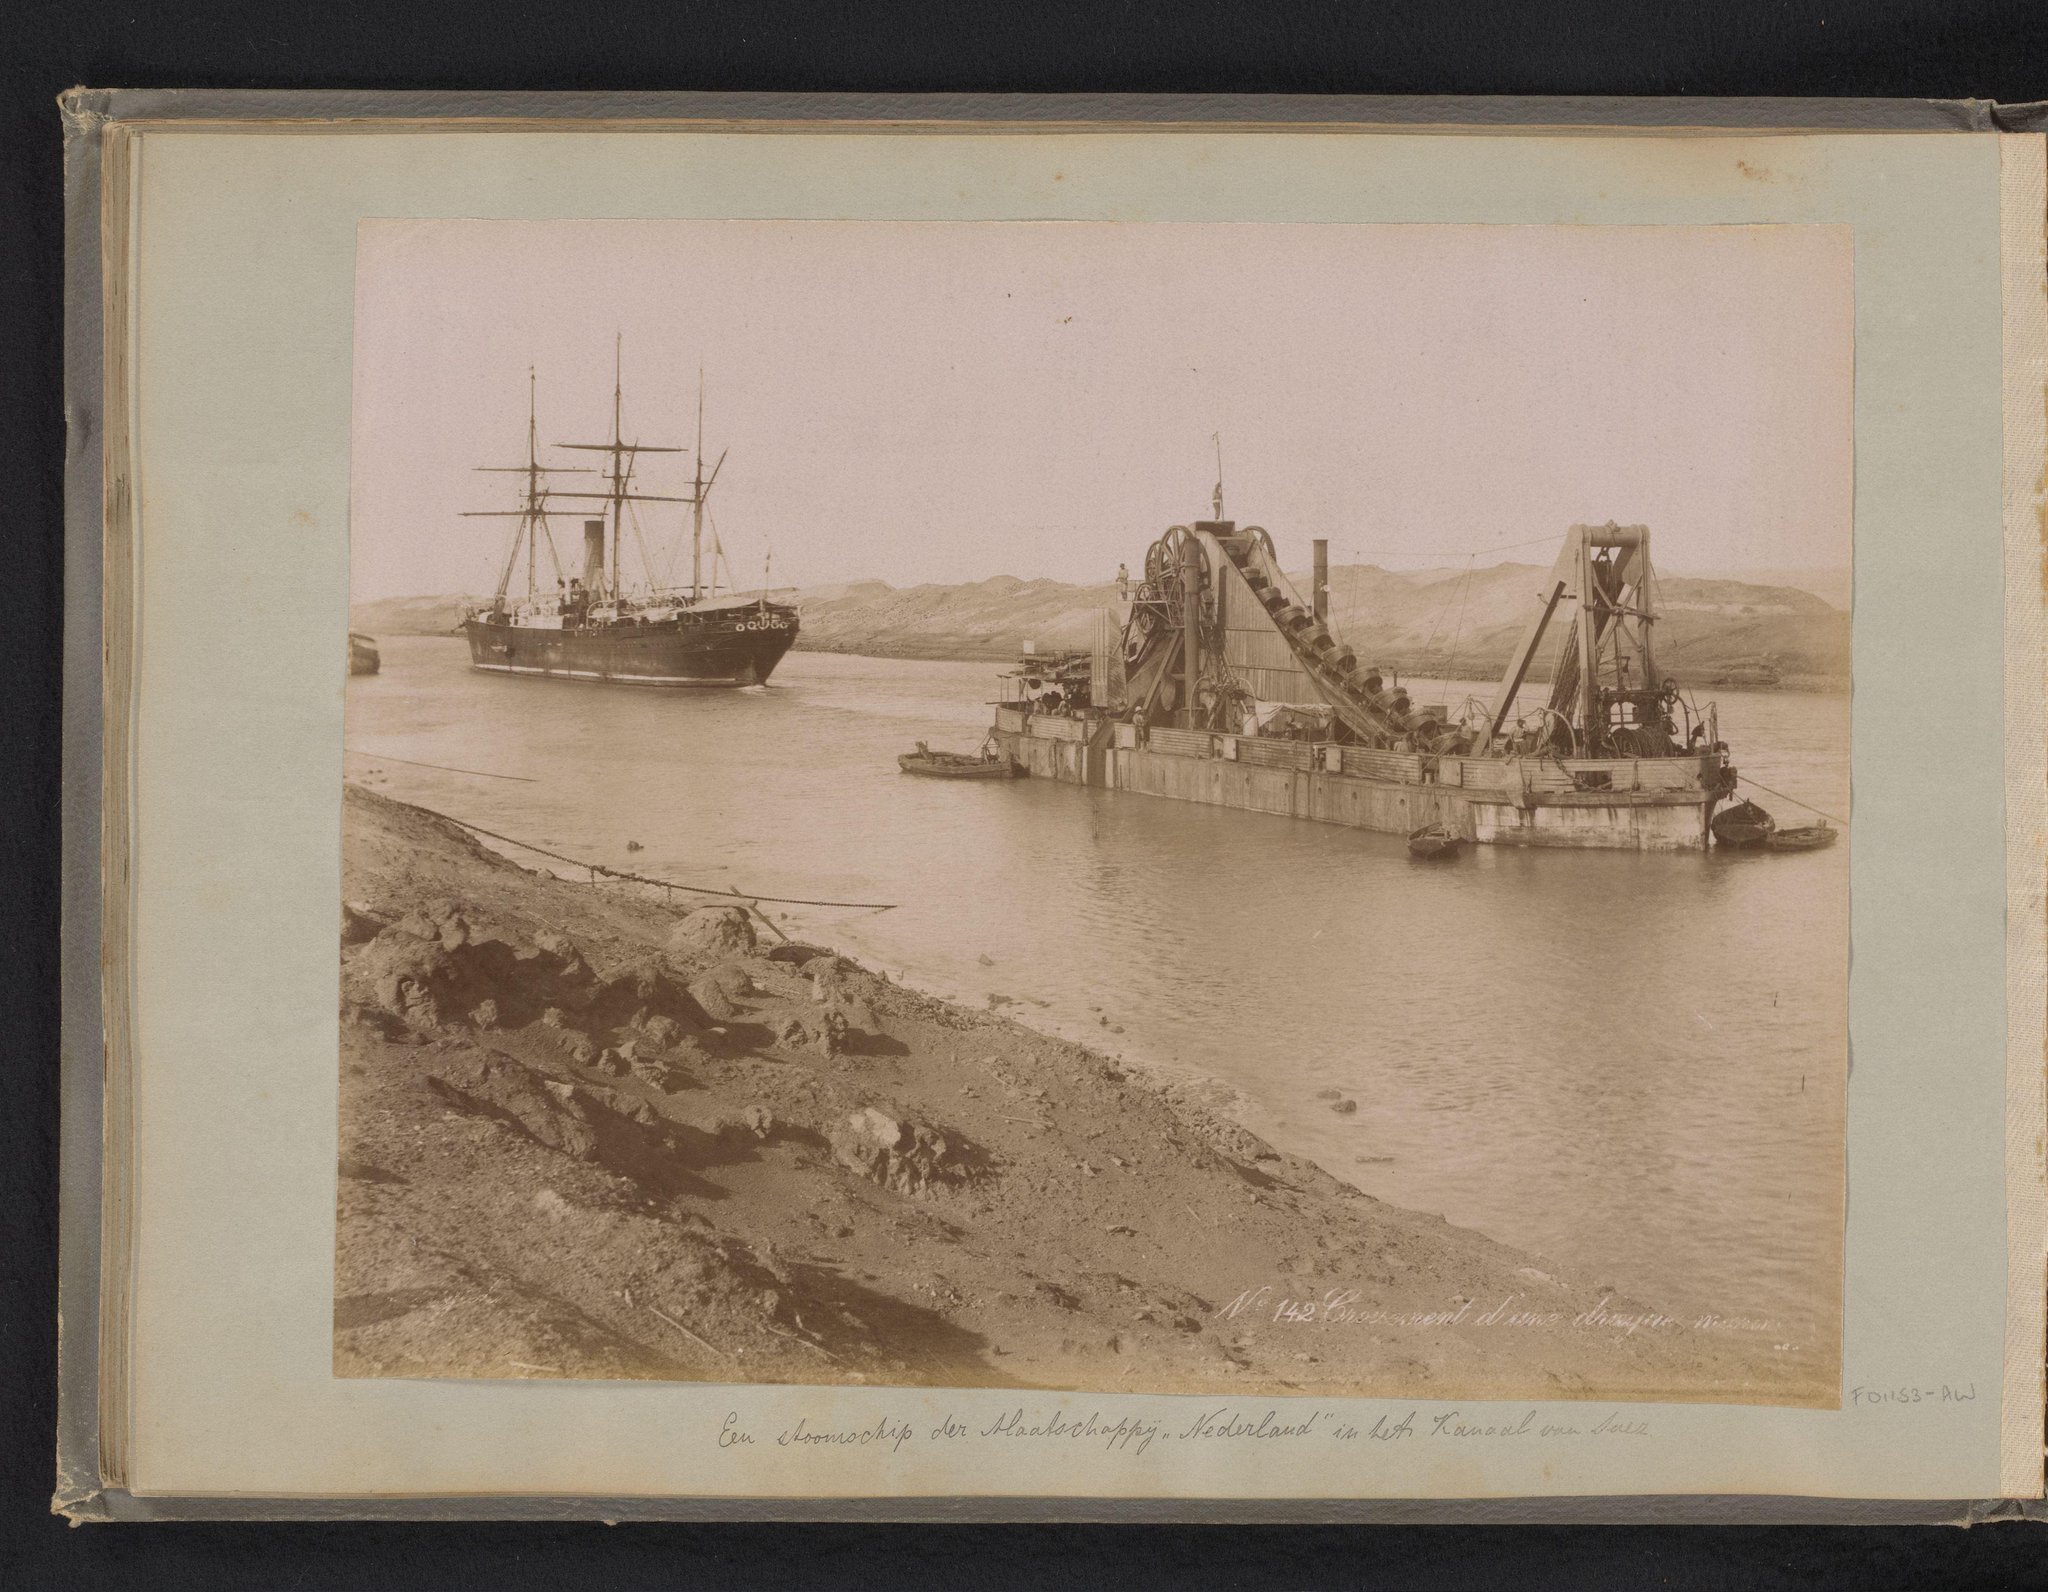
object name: photograph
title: Stoomschip in het Suezkanaal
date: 1885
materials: photographic support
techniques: albumen print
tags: landscapes with waters, waterscapes, seascapes (in the temperate zone), steamship, motorship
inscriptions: inscription: ‘No 142. Croisement d'une dragon maron’